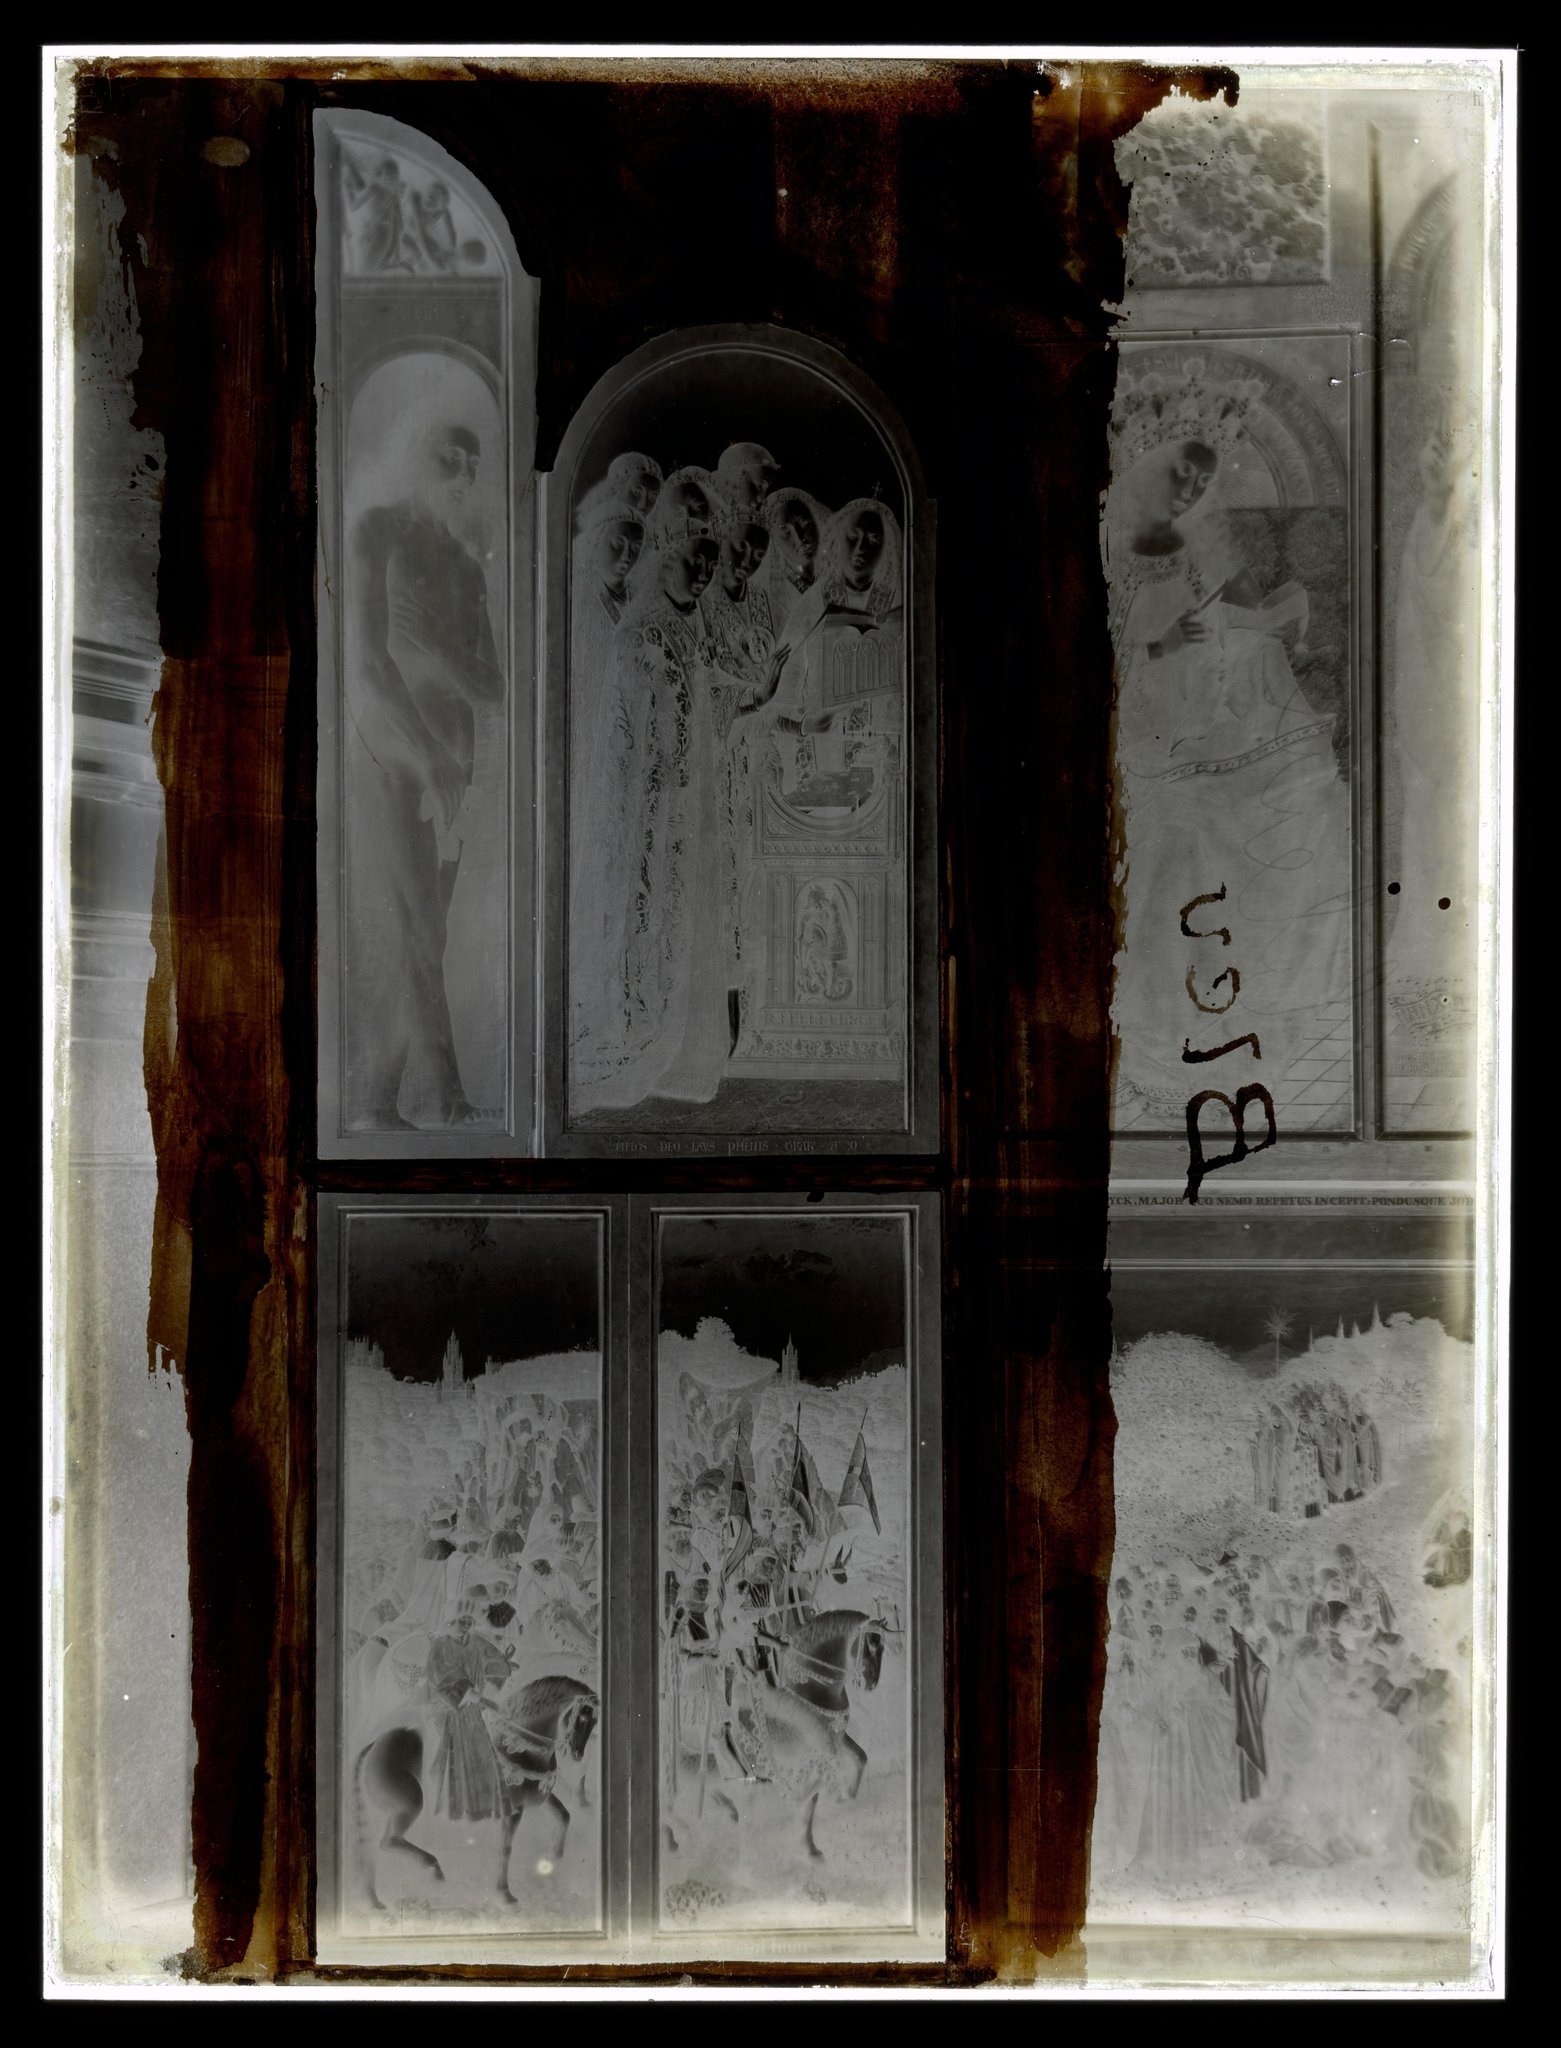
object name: negative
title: Deelnegatief van het linkerpaneel van het altaarstuk De aanbidding van het Lam Gods door Hubert en Jan van Eyck, opgesteld in de Sint-Baafskathedraal, Gent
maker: Anonymous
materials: glass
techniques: gelatin silver negative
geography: ghent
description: Gefotografeerd door een rood-, groen- en blauwfilter.